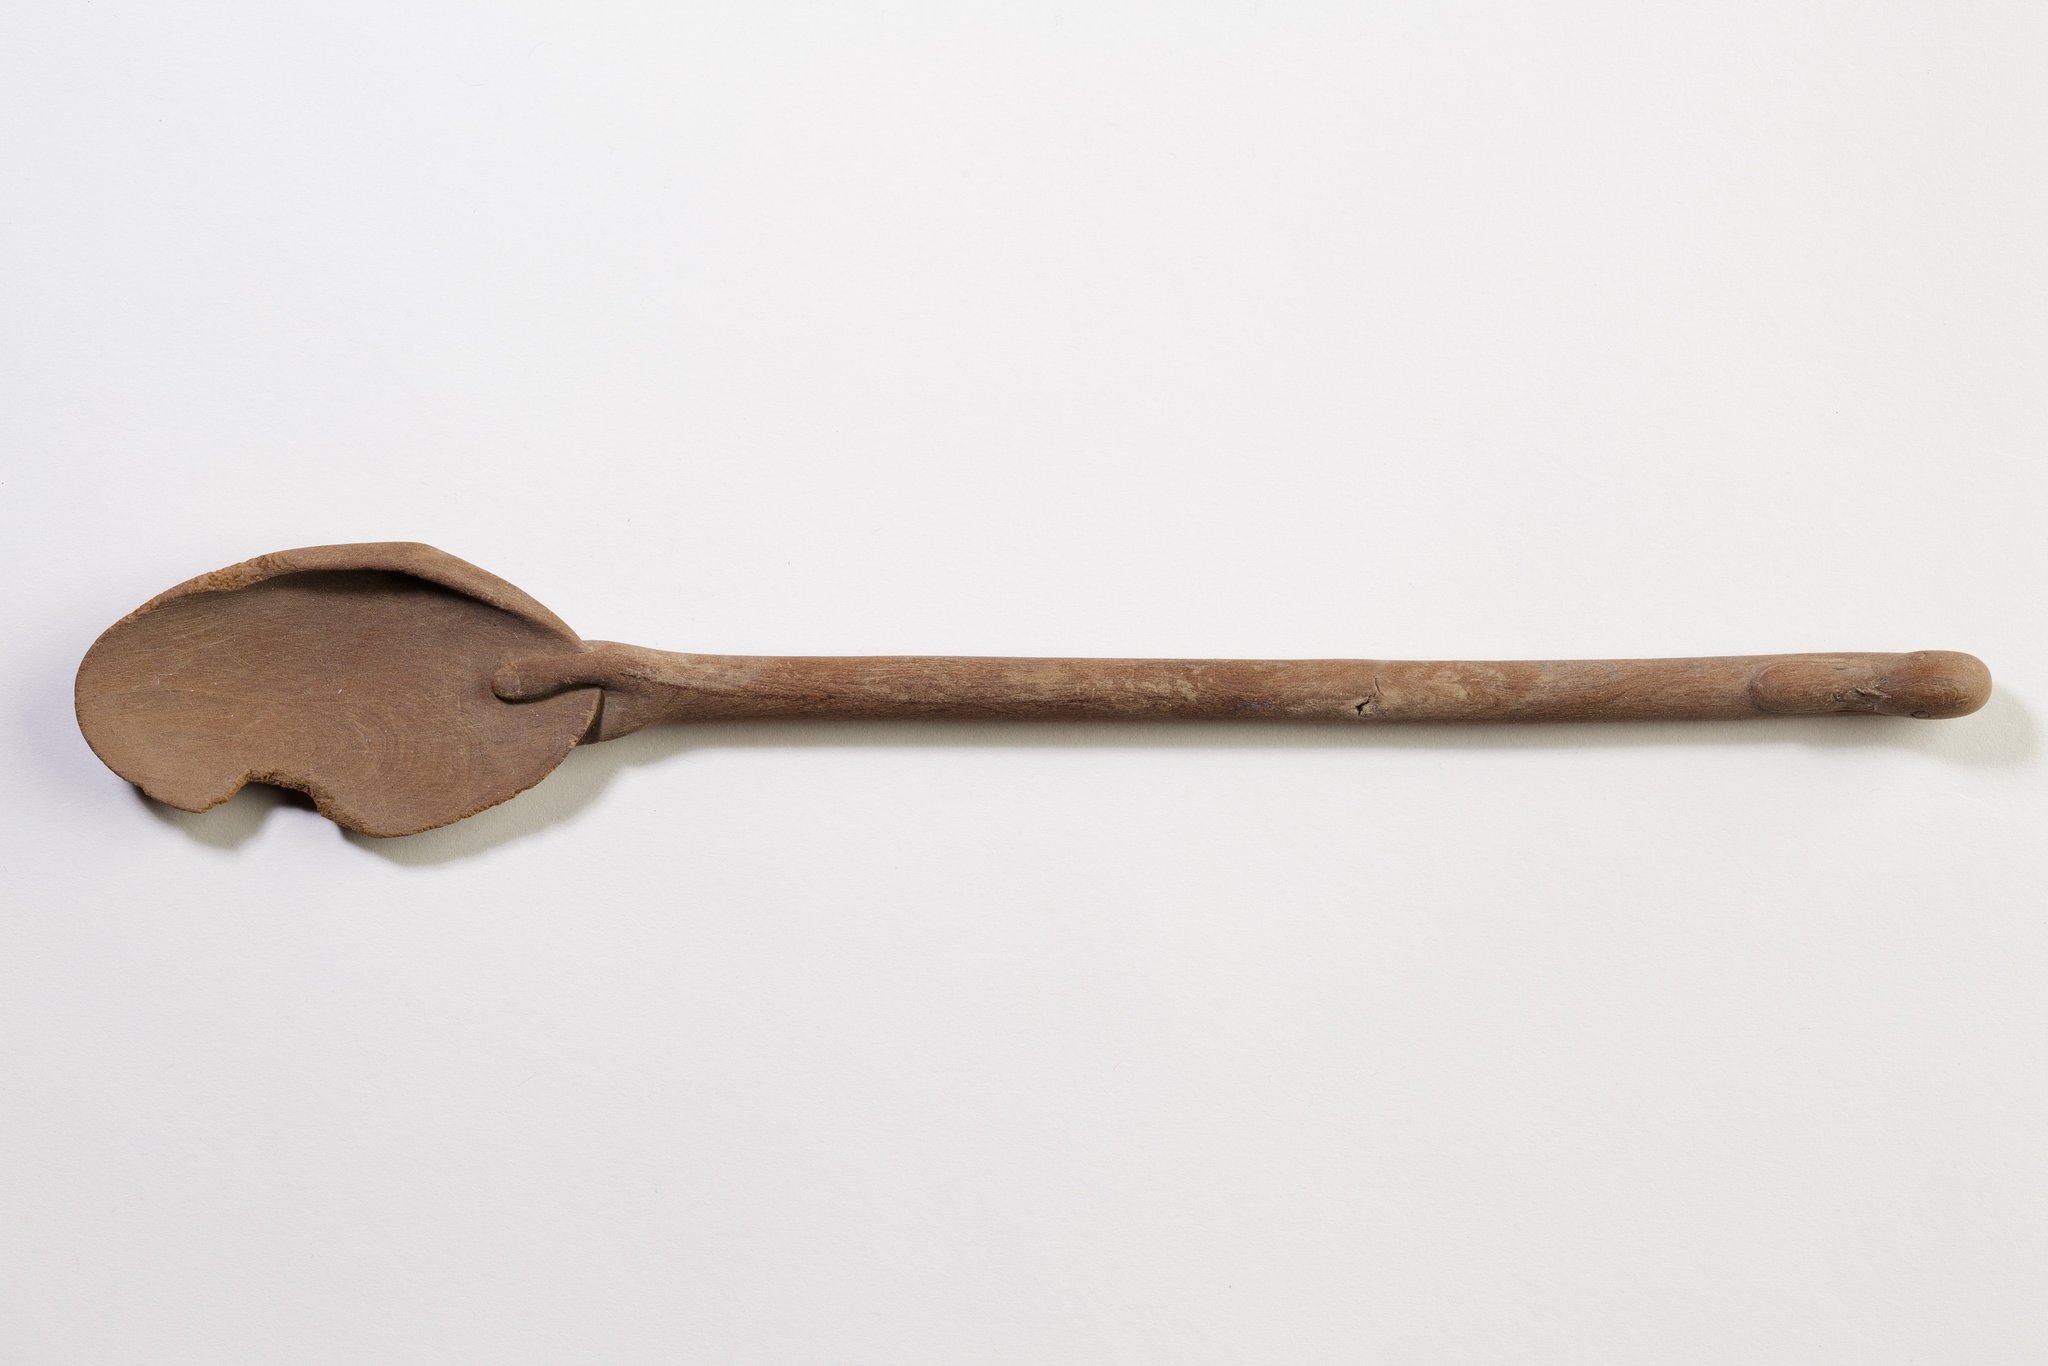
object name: spoon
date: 1550-1295 BCE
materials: wood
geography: egypt